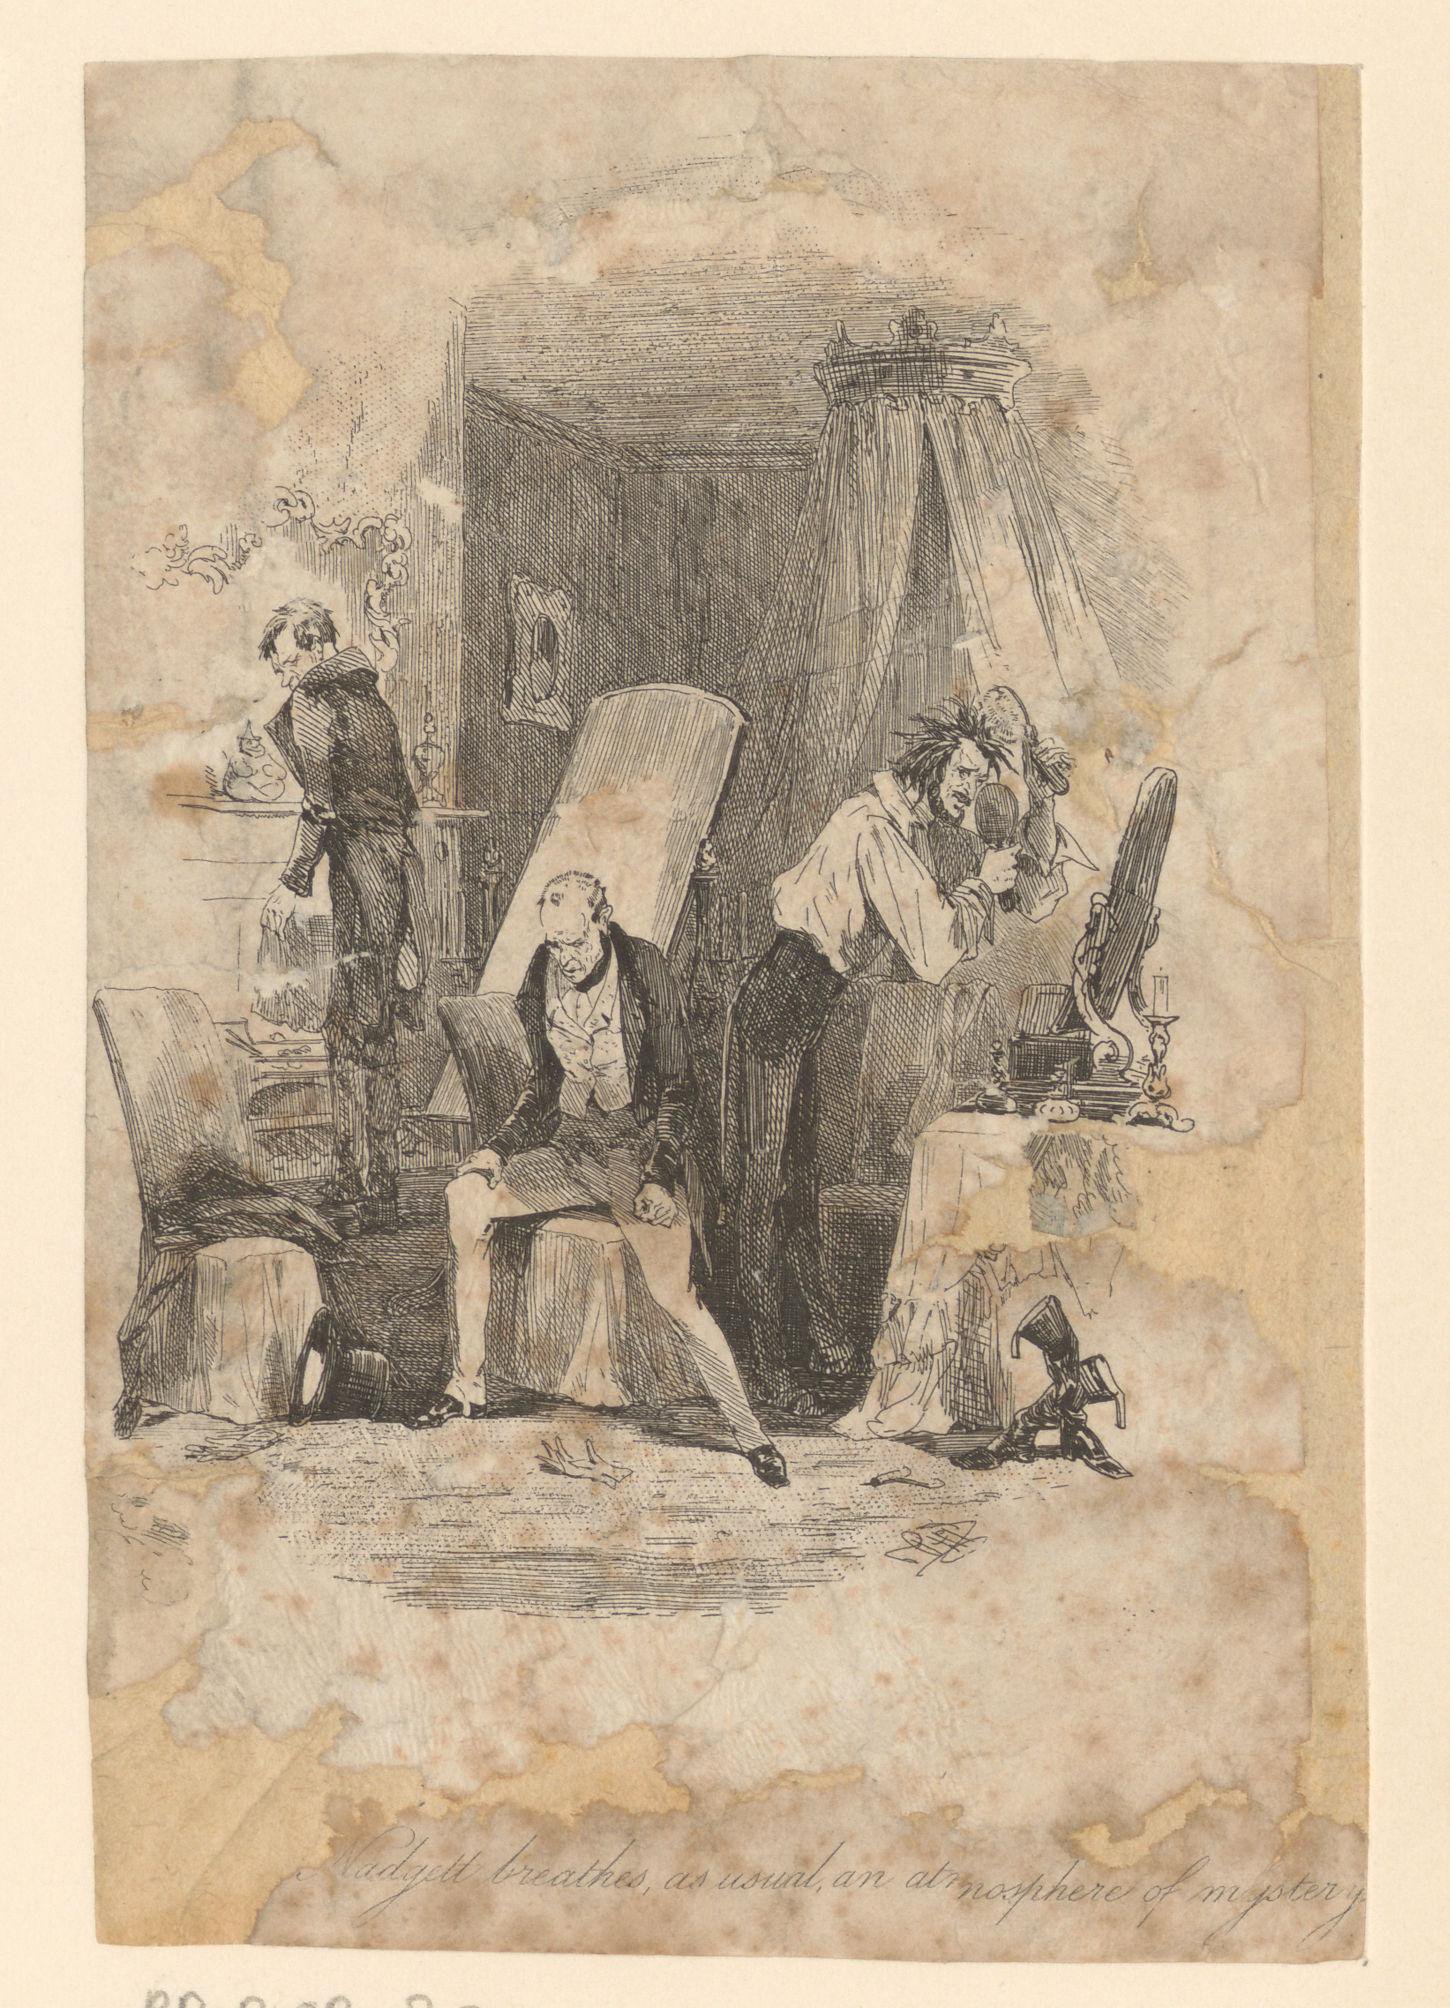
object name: print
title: Nadgett breathes, as usual, an atmosphere of mystery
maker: hablot knight browne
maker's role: print maker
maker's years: 1815-1882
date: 1802-1844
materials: paper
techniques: etching, roulette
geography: london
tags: comb, brush and other tools (care of the hair), bedroom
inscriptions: collector's mark: Lugt 2228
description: Prent uit: Dickens, Charles. The Life and Adventures of Martin Chuzzlewit. Londen: Chapman and Hall, 1842-1844. Het boek werd tussen 1842 en 1844 in delen uitgegeven. Deze prent hoort bij hoofdstuk 38, uitgegeven in februari 1844.